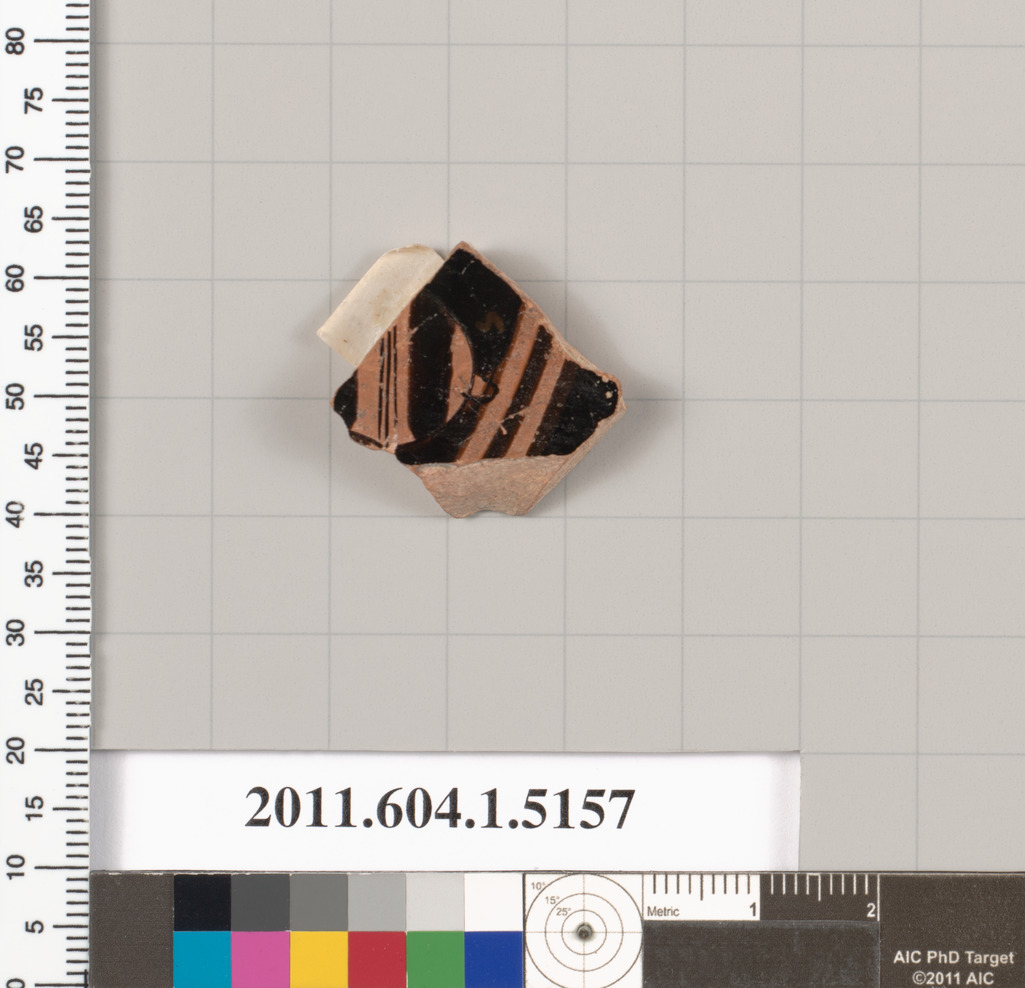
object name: kylix fragment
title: Terracotta fragment of a kylix (drinking cup)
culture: greek, attic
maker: epidromos painter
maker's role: artist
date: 520-500 BCE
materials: terracotta